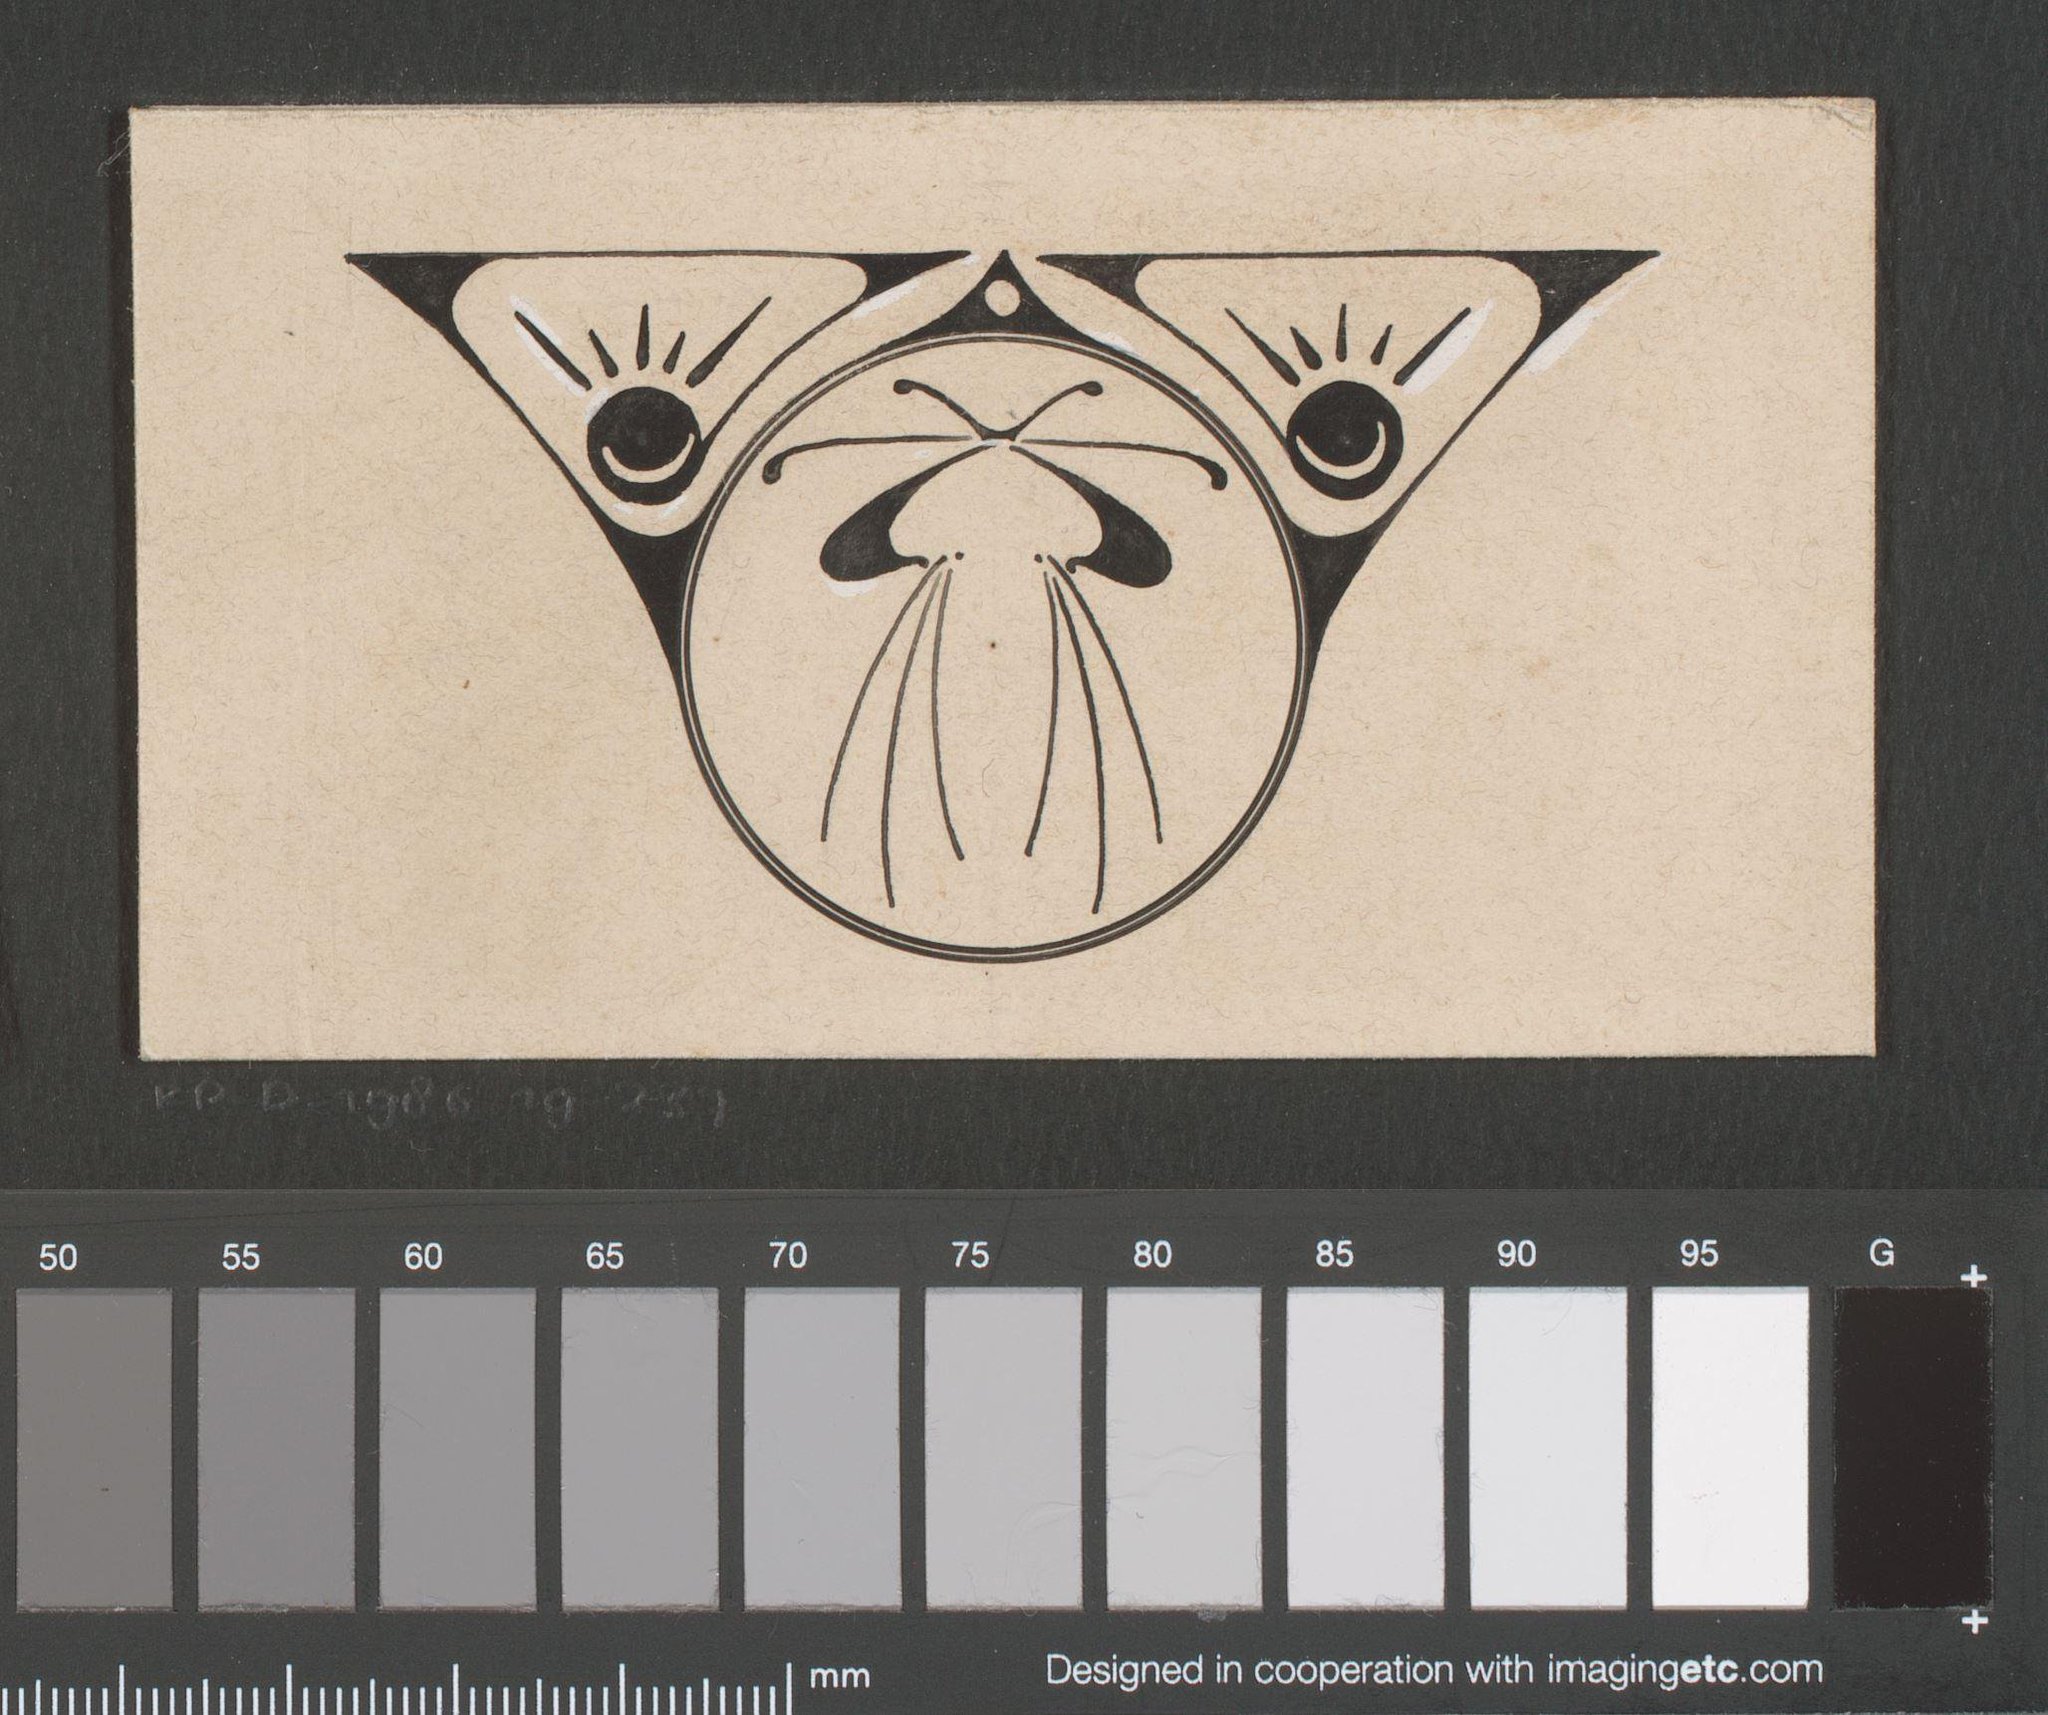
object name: drawing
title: Vignet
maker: reinier willem petrus de vries (1874-1953)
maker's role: draughtsman, print maker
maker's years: 1874-1953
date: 1884-1952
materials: cardboard, paint, ink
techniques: brush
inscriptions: collector's mark: ‘R:MVS.’